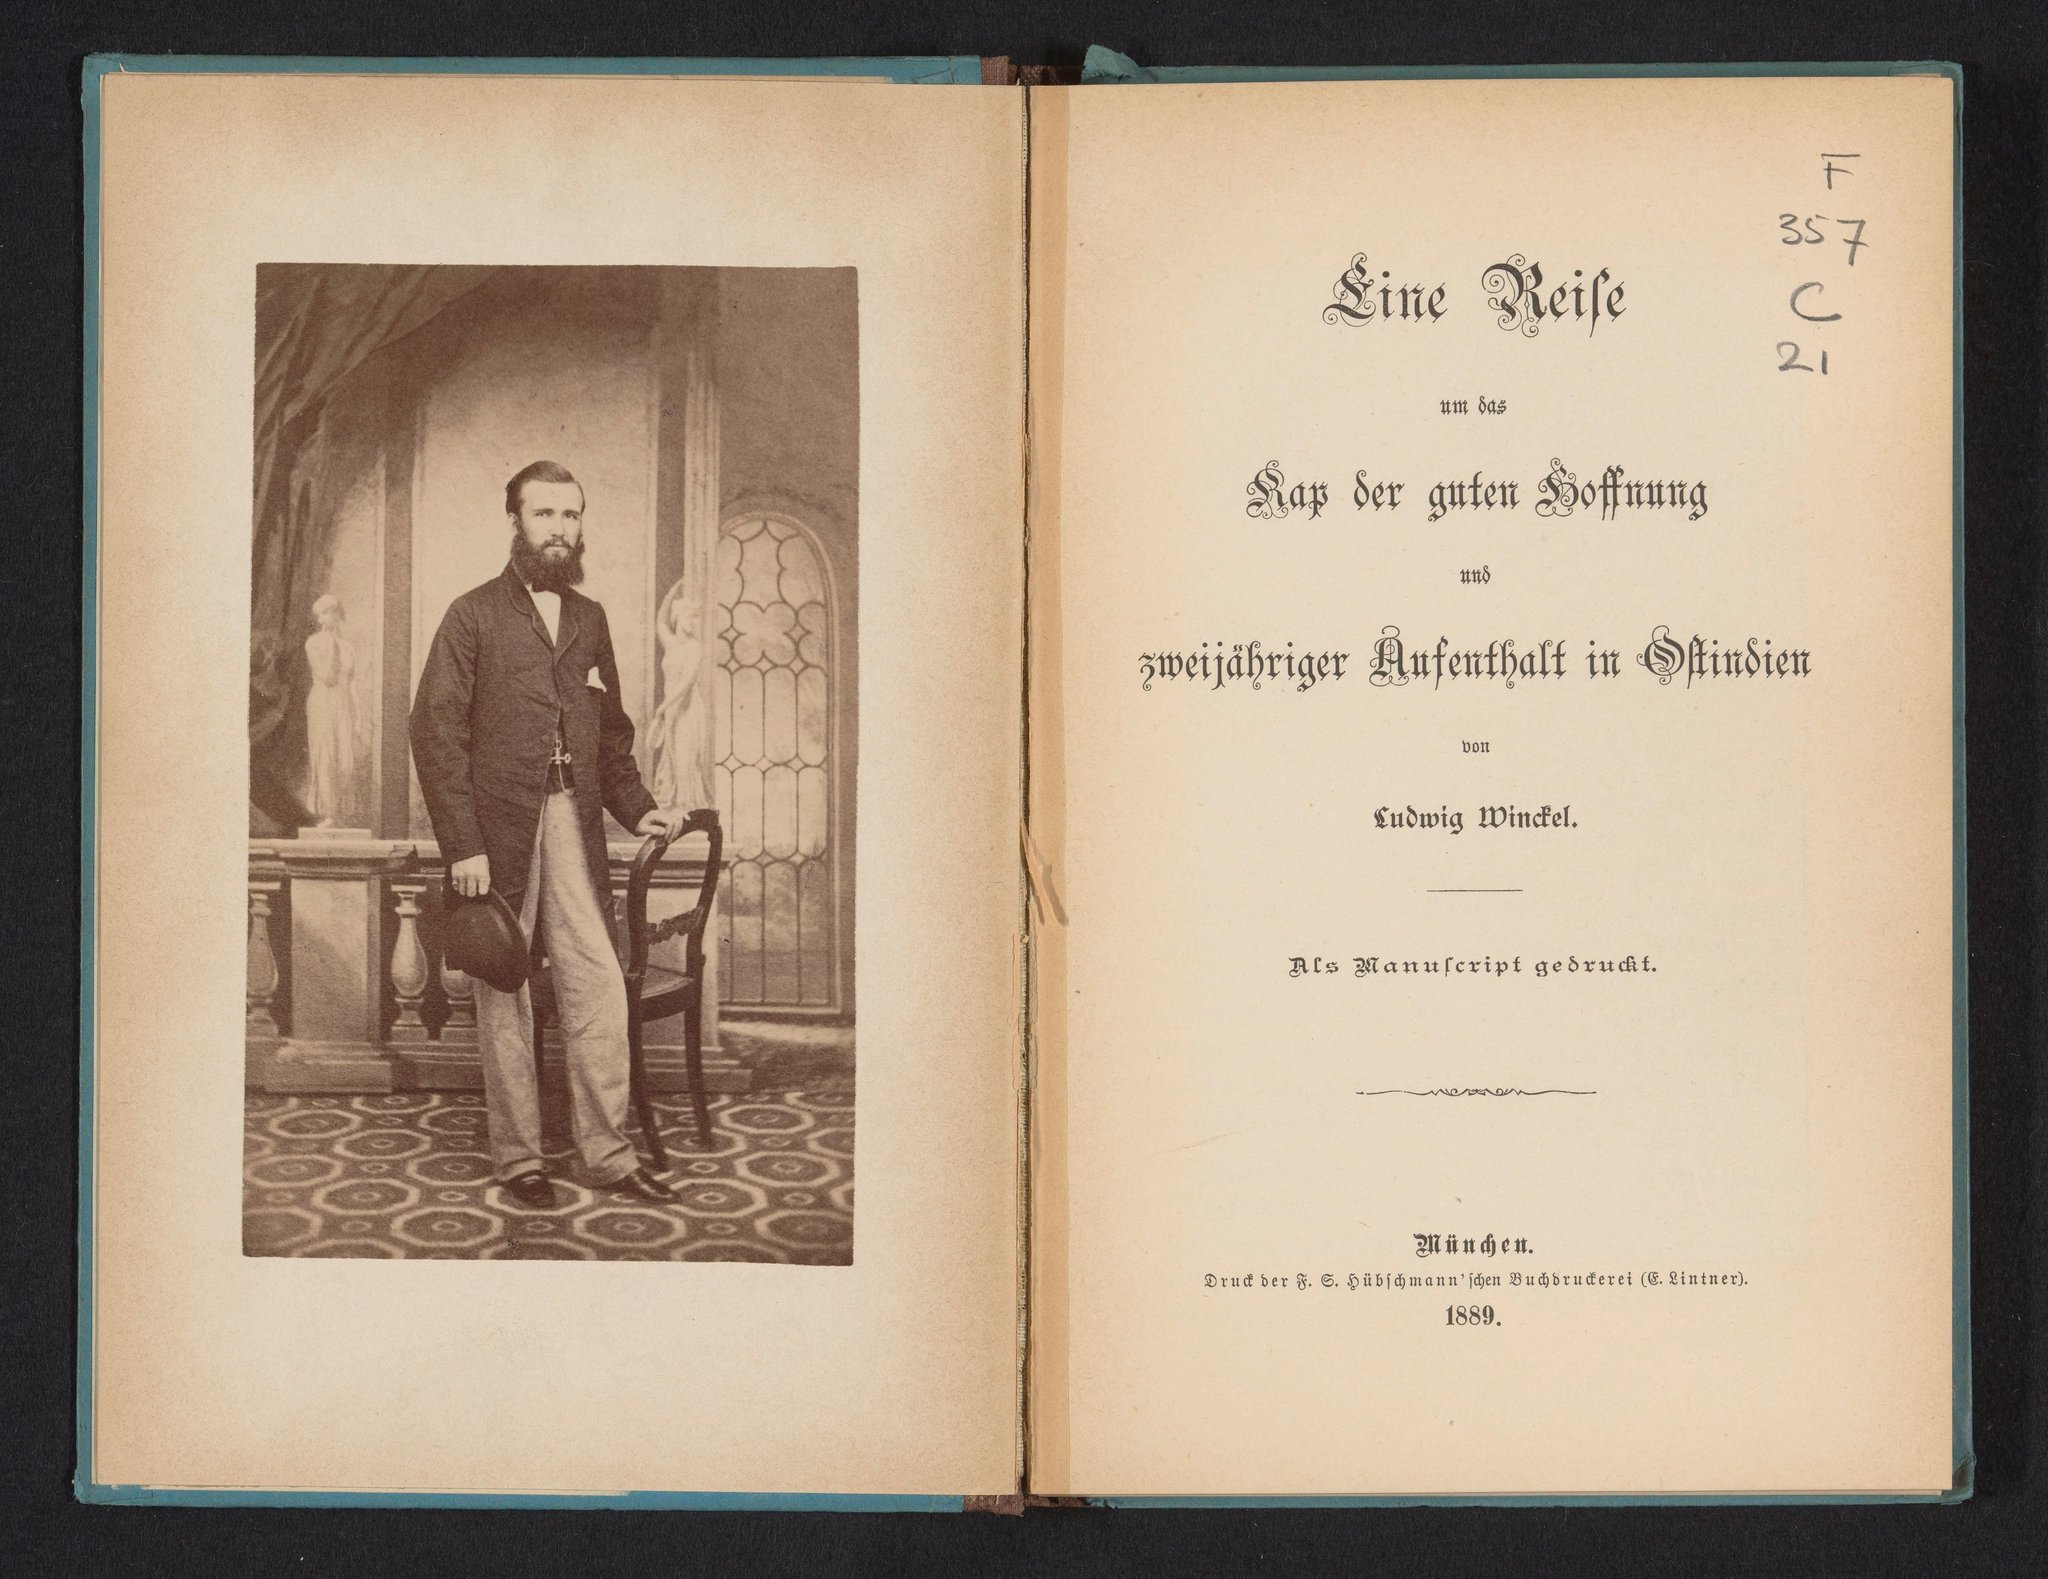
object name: book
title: Eine Reise um das Kap der guten Hoffnung und zweijähriger Aufenthalt in Ostindien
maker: ludwig winckel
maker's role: schrijver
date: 1889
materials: cardboard, linen, paper, photographic support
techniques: albumen print, printing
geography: munich